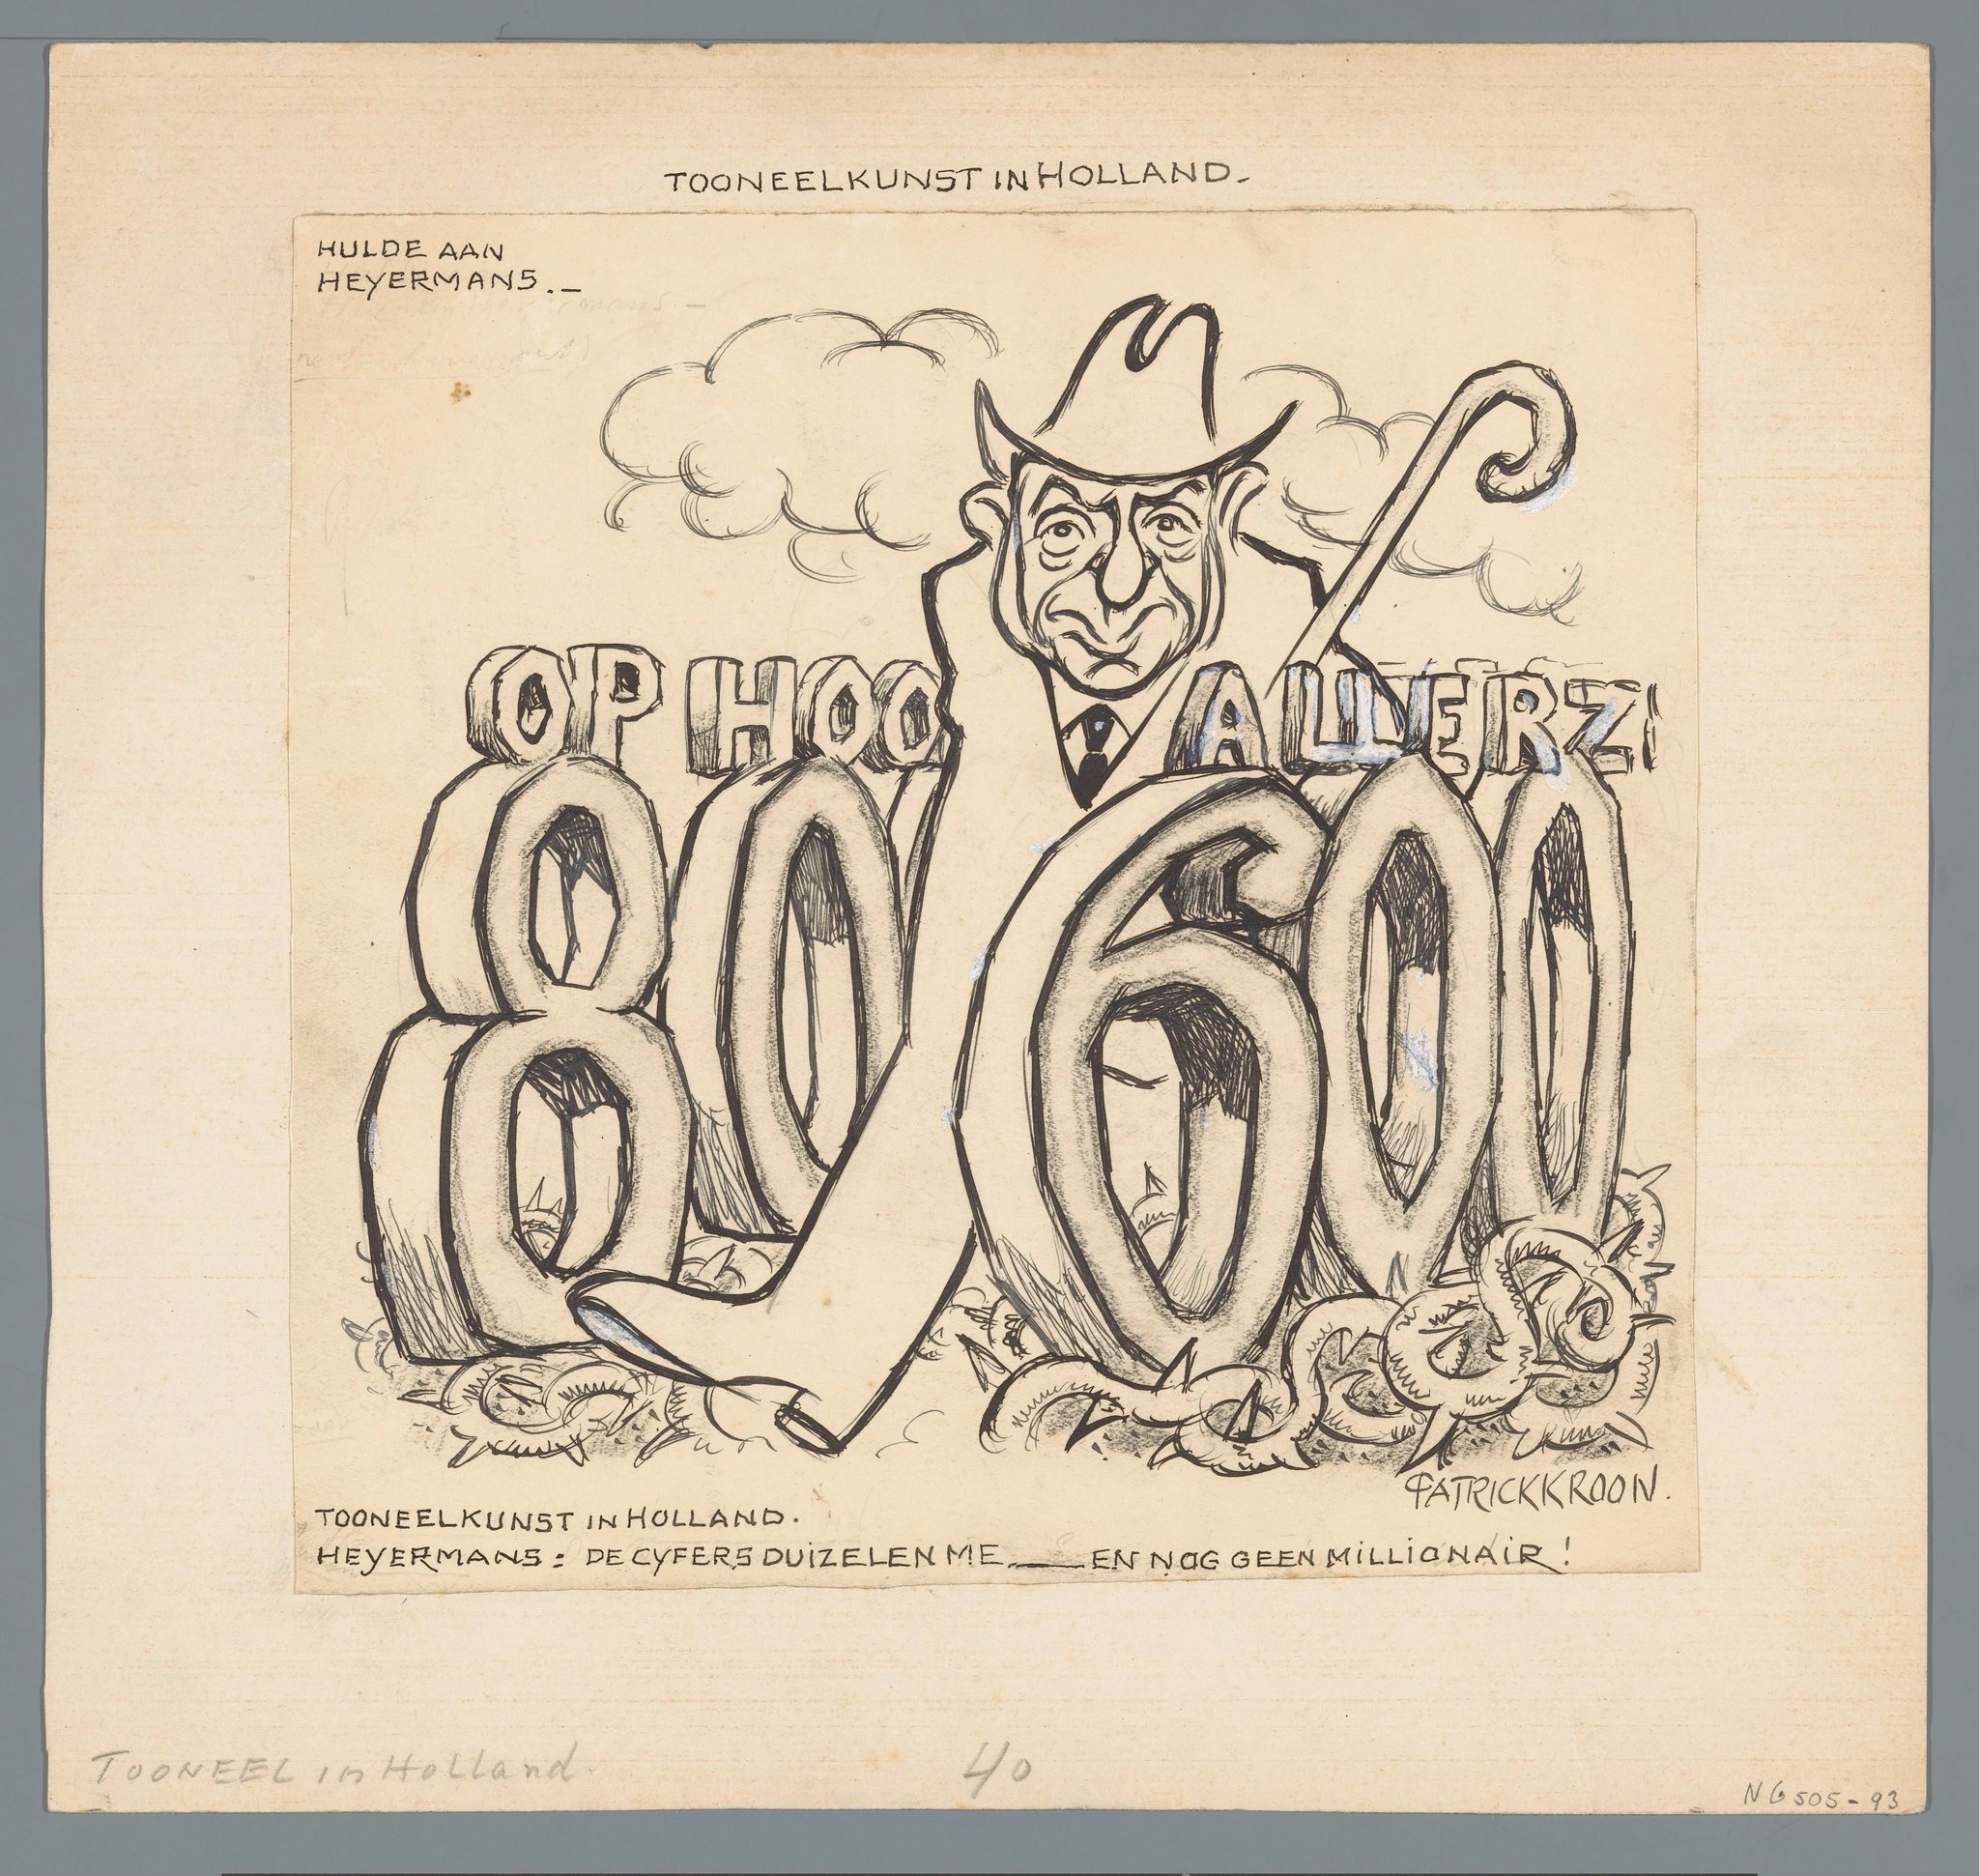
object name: cartoon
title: Succes van Herman Heijermans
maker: patricq kroon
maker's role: draughtsman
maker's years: 1862-1941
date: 1900-1924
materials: paint, ink, paper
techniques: pen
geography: netherlands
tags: rotterdam, herman heijermans, historical persons, writer, poet, author, political caricatures and satires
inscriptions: inscription: ‘Toneelkunst in Holland / Hulde aan Heyermans ...’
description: Succesvolle toneelstukken van Herman Heijermans: Op hoop van zegen en Allerzielen. Ontwerp voor een cartoon in een krant.